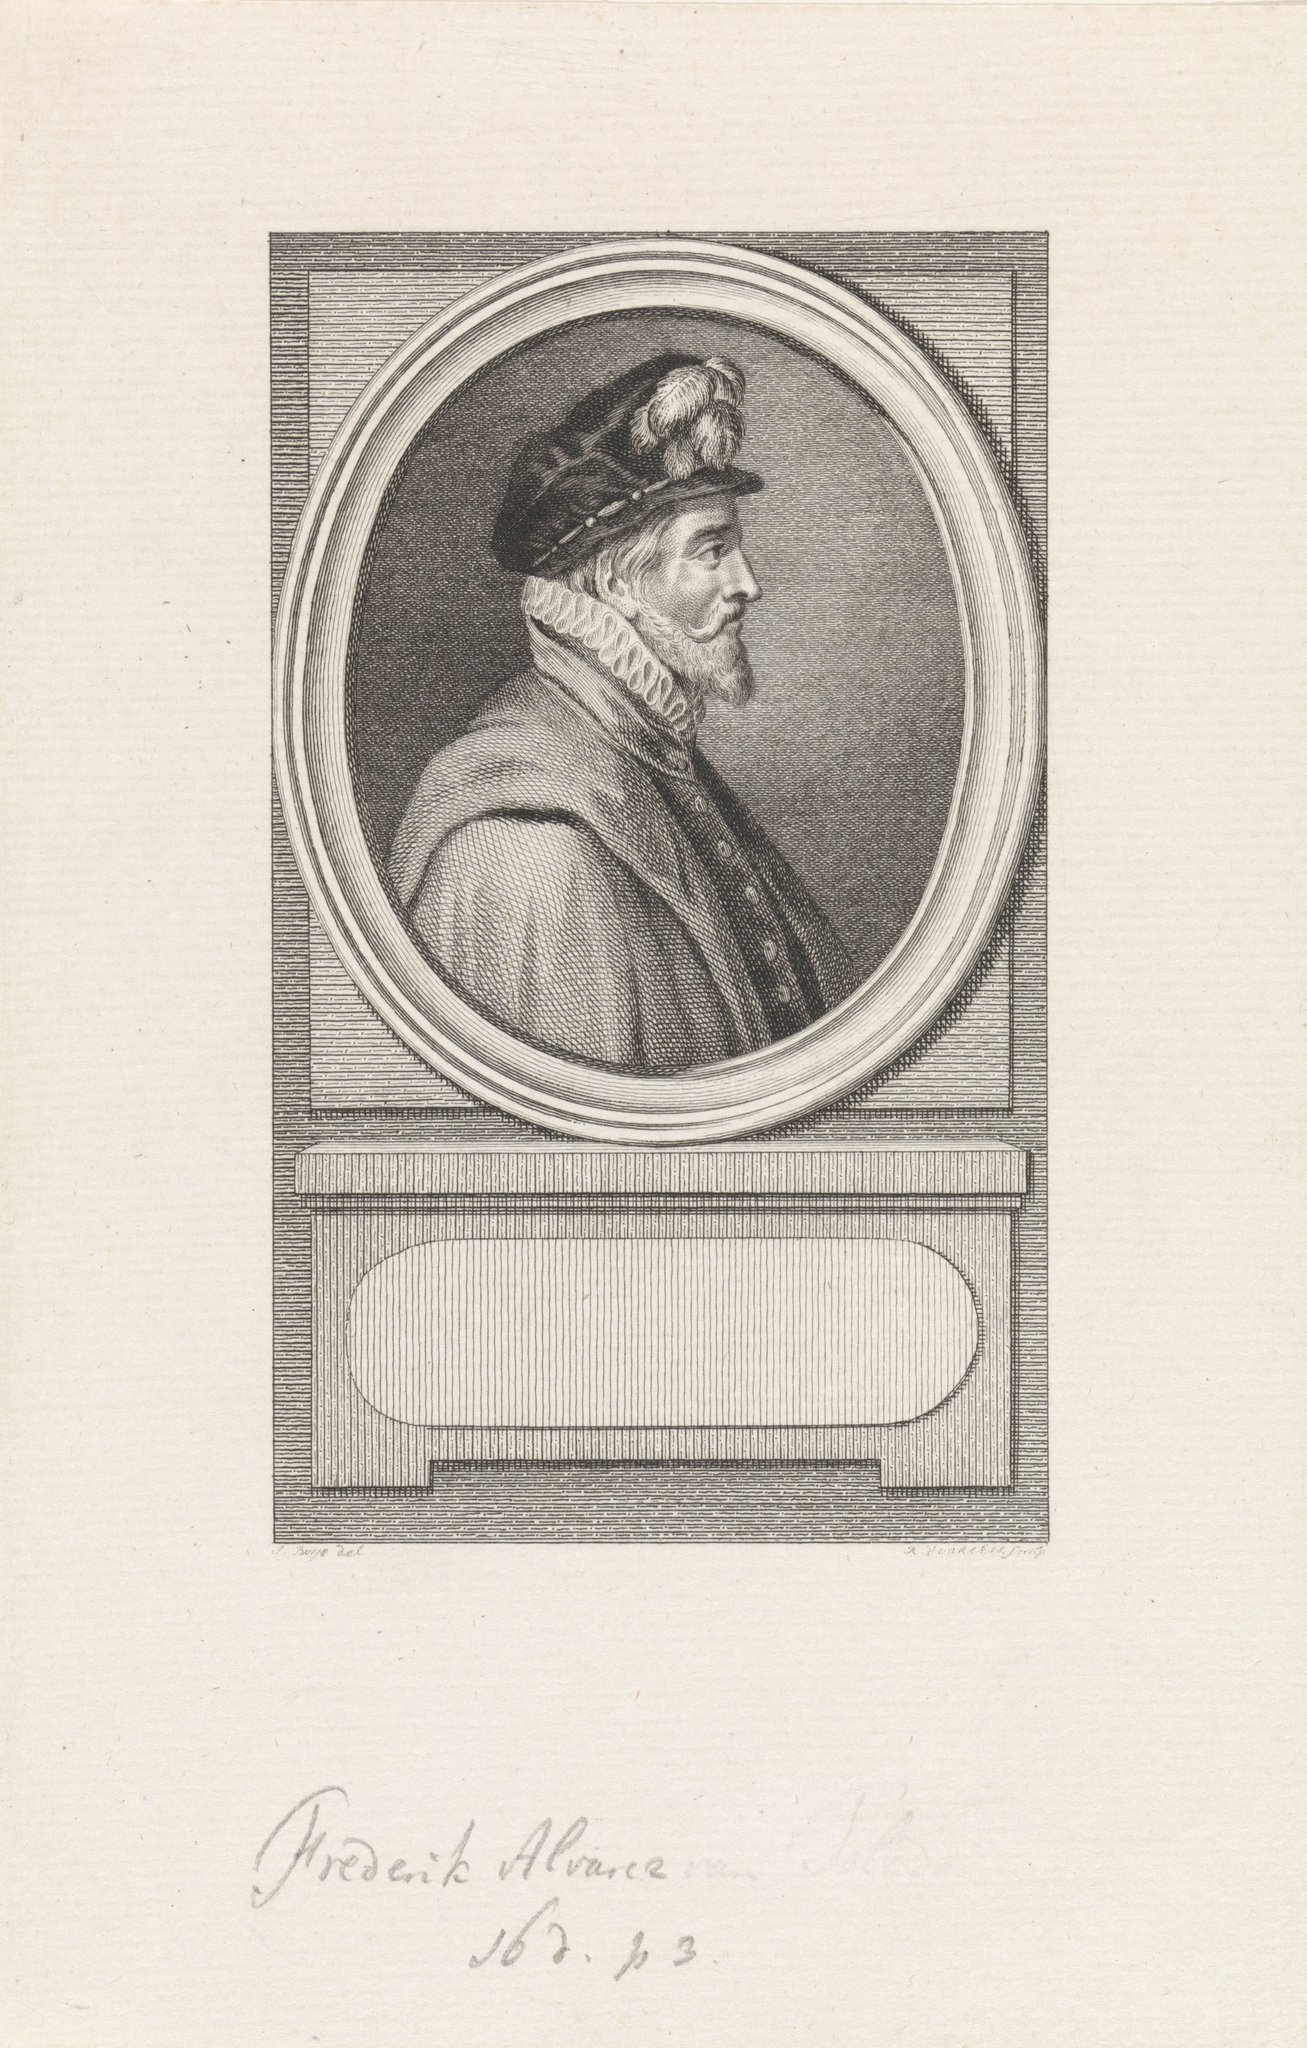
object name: print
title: Portret van Alessandro Farnese, hertog van Parma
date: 1786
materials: paper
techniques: engraving, etching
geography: amsterdam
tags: lissabon, bevelhebber, fadrique alvarez de toledo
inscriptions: collector's mark: Lugt 240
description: Latere staat prent gebruikt als boekillustratie in: Kok, Jacobus. Vaderlandsch woordenboek : met kaarten, plaaten en pourtraitten. Amsterdam: Johannes Allart, 1785-1796. Deel XVI.